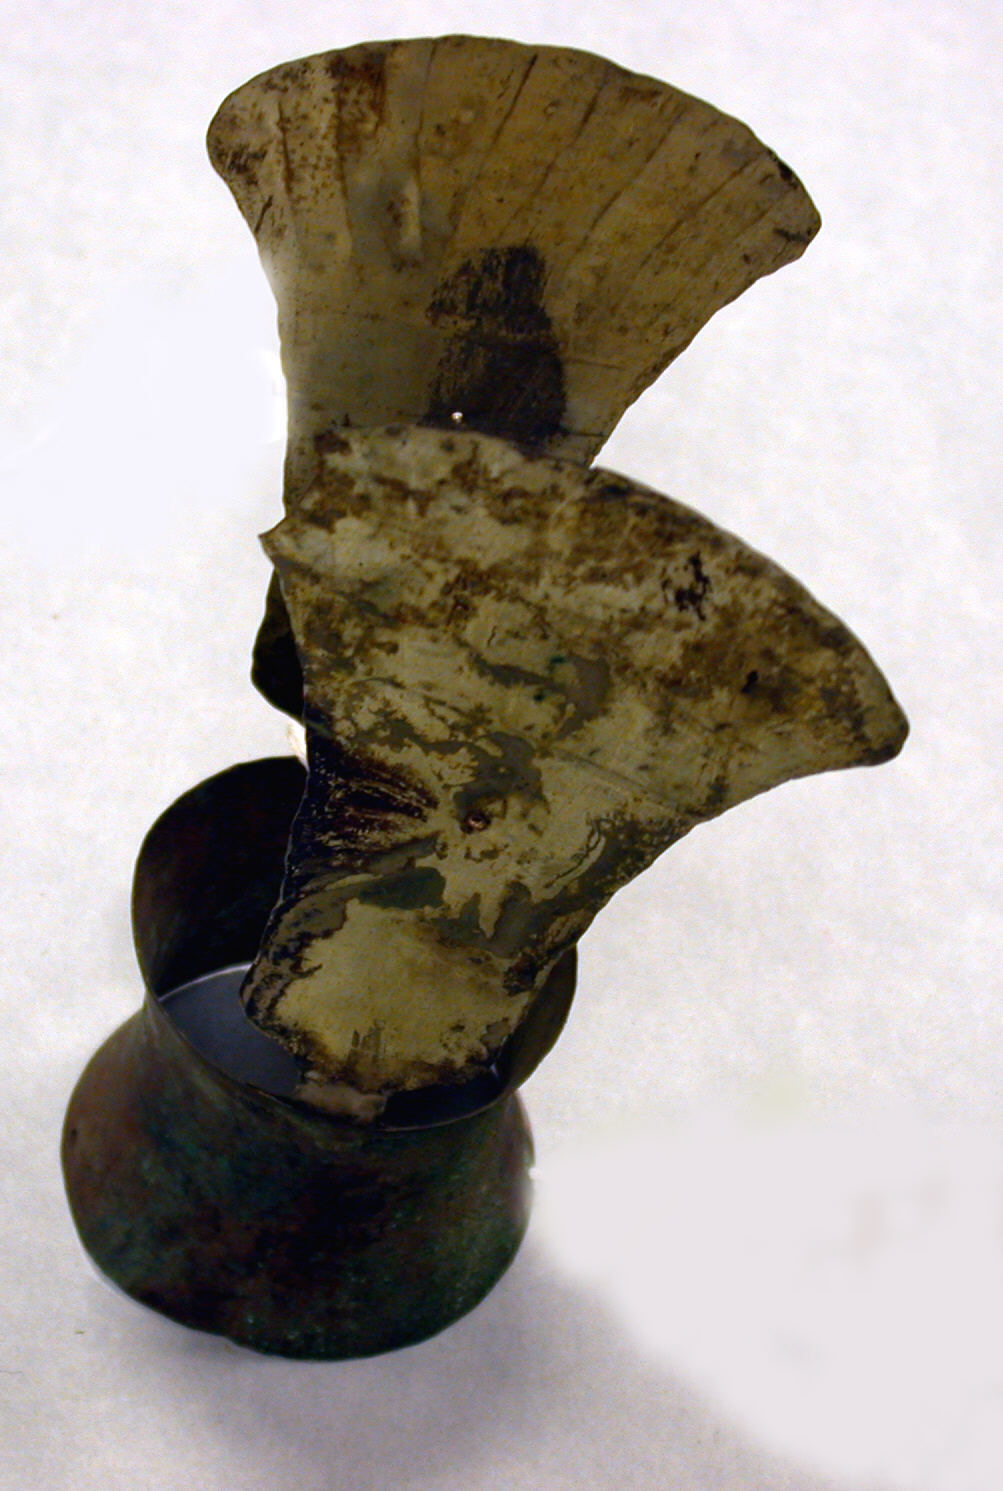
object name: crown base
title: Hammered Silver Miniature Crown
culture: peruvian, north or central coast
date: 1001-1566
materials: gilt, silver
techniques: hammering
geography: peru